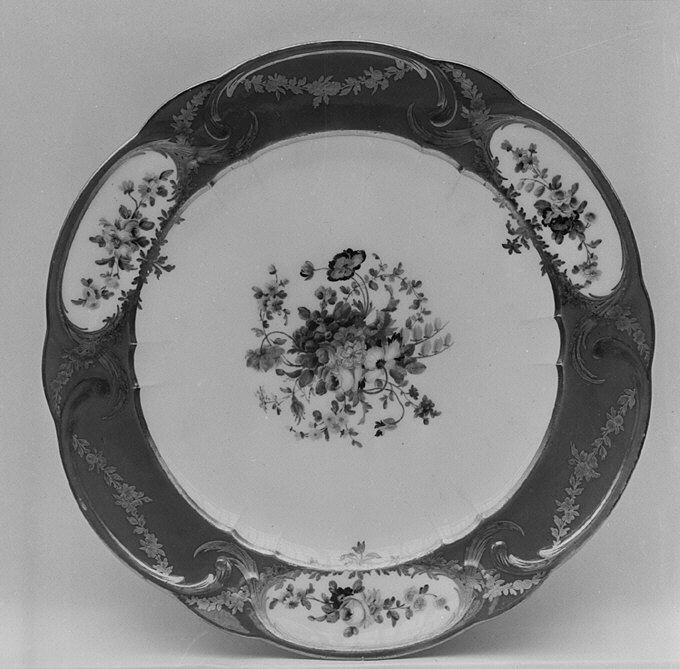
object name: plate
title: Plate (assiette à palmes) (1 of 102) (part of a service)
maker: sèvres manufactory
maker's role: manufactory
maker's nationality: french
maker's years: 1740-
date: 1772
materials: soft paste porcelain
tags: flowers